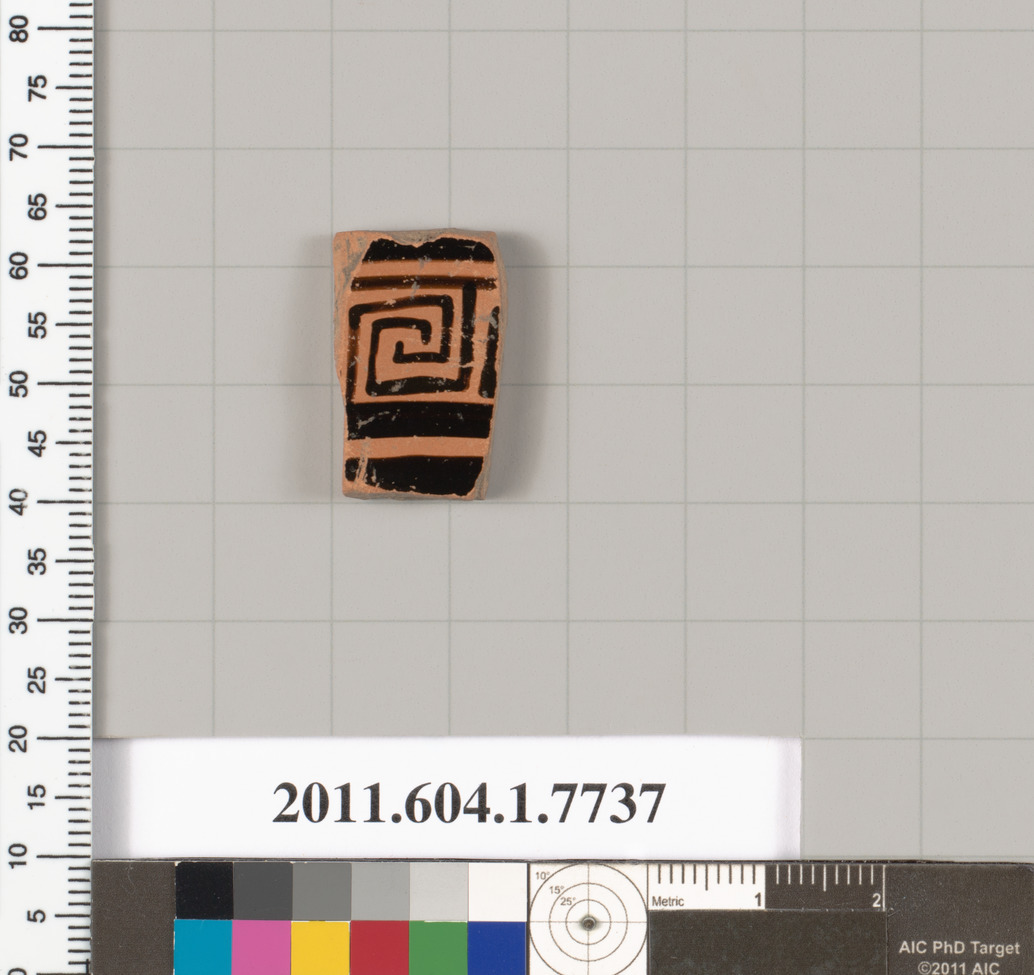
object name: kylix fragment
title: Terracotta fragment of a kylix (drinking cup)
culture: greek, attic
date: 460-450 BCE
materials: terracotta